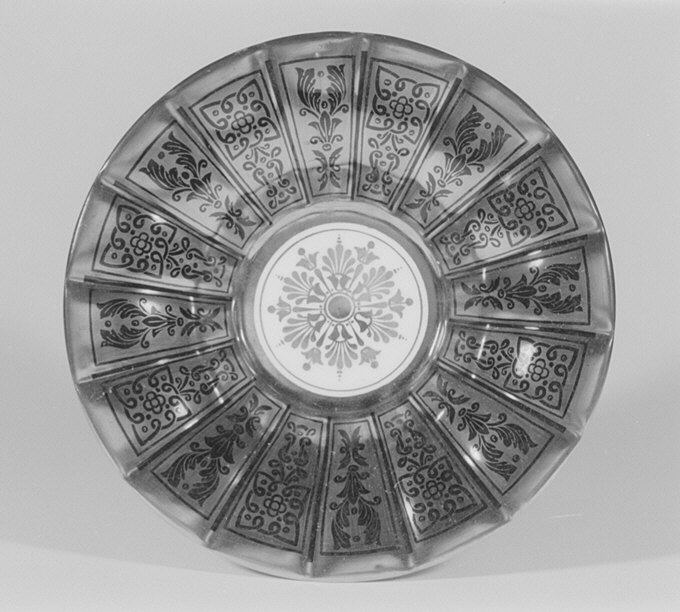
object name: saucer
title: Saucers (12) (part of a tea and coffee service)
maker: imperial porcelain manufactory, st. petersburg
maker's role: manufactory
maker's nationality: russian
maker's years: 1744-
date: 1834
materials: hard paste porcelain